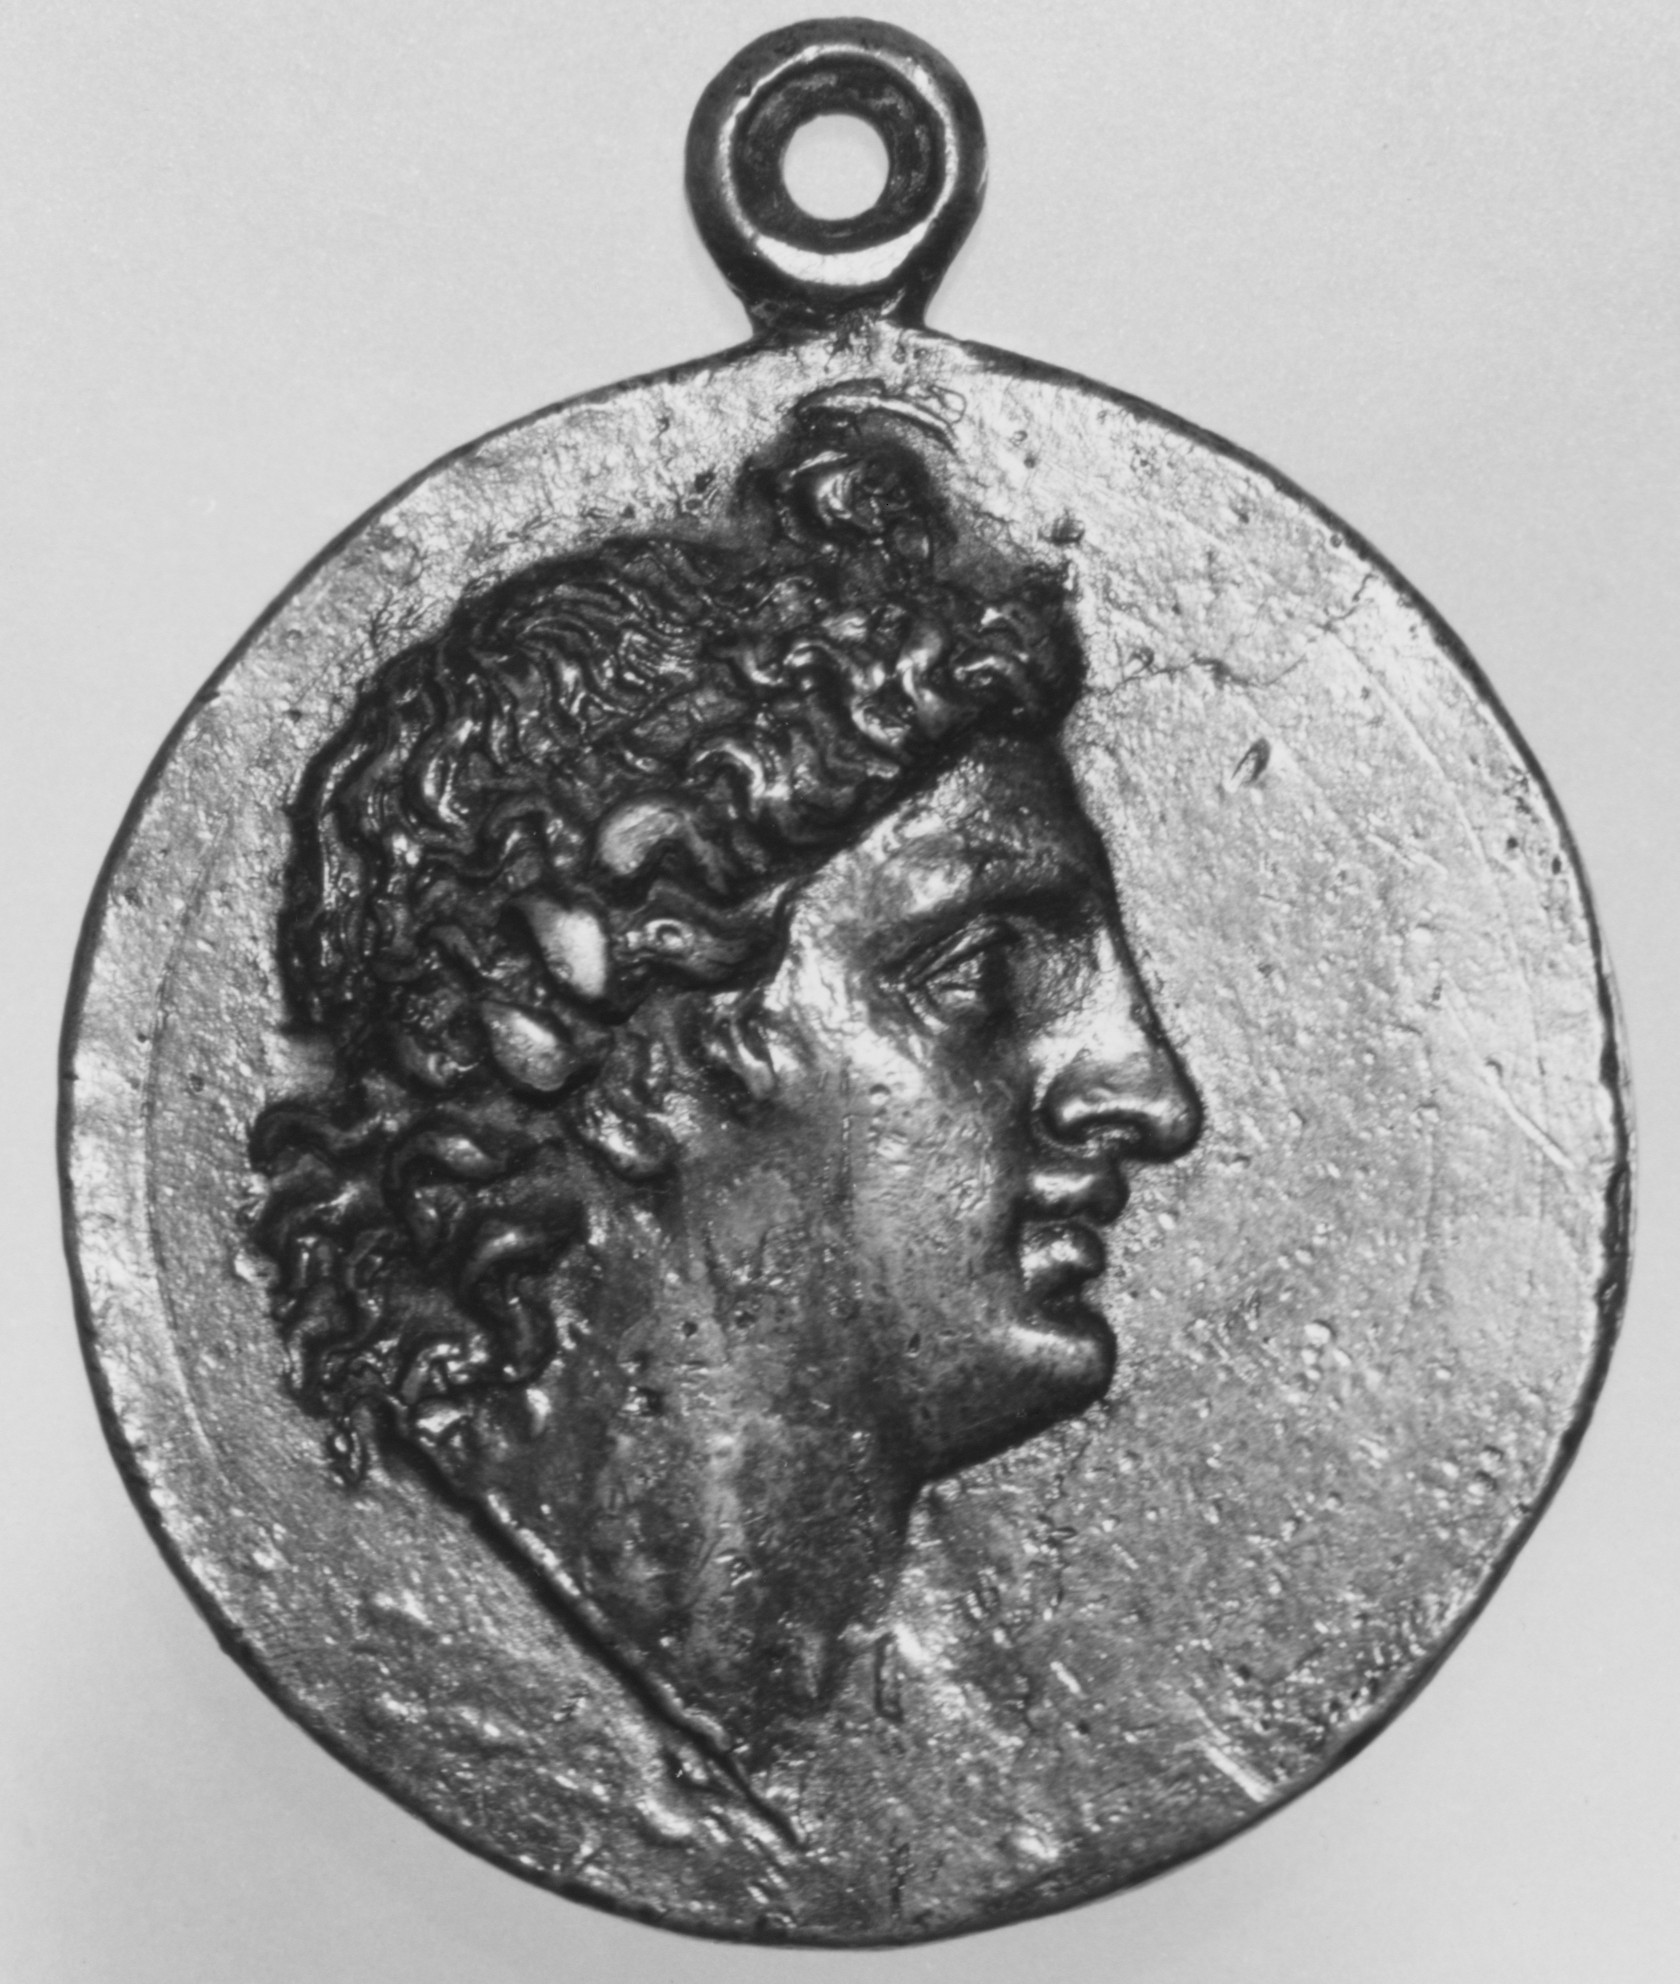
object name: medal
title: Alexander the Great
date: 1501-1600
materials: bronze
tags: alexander the great,profiles